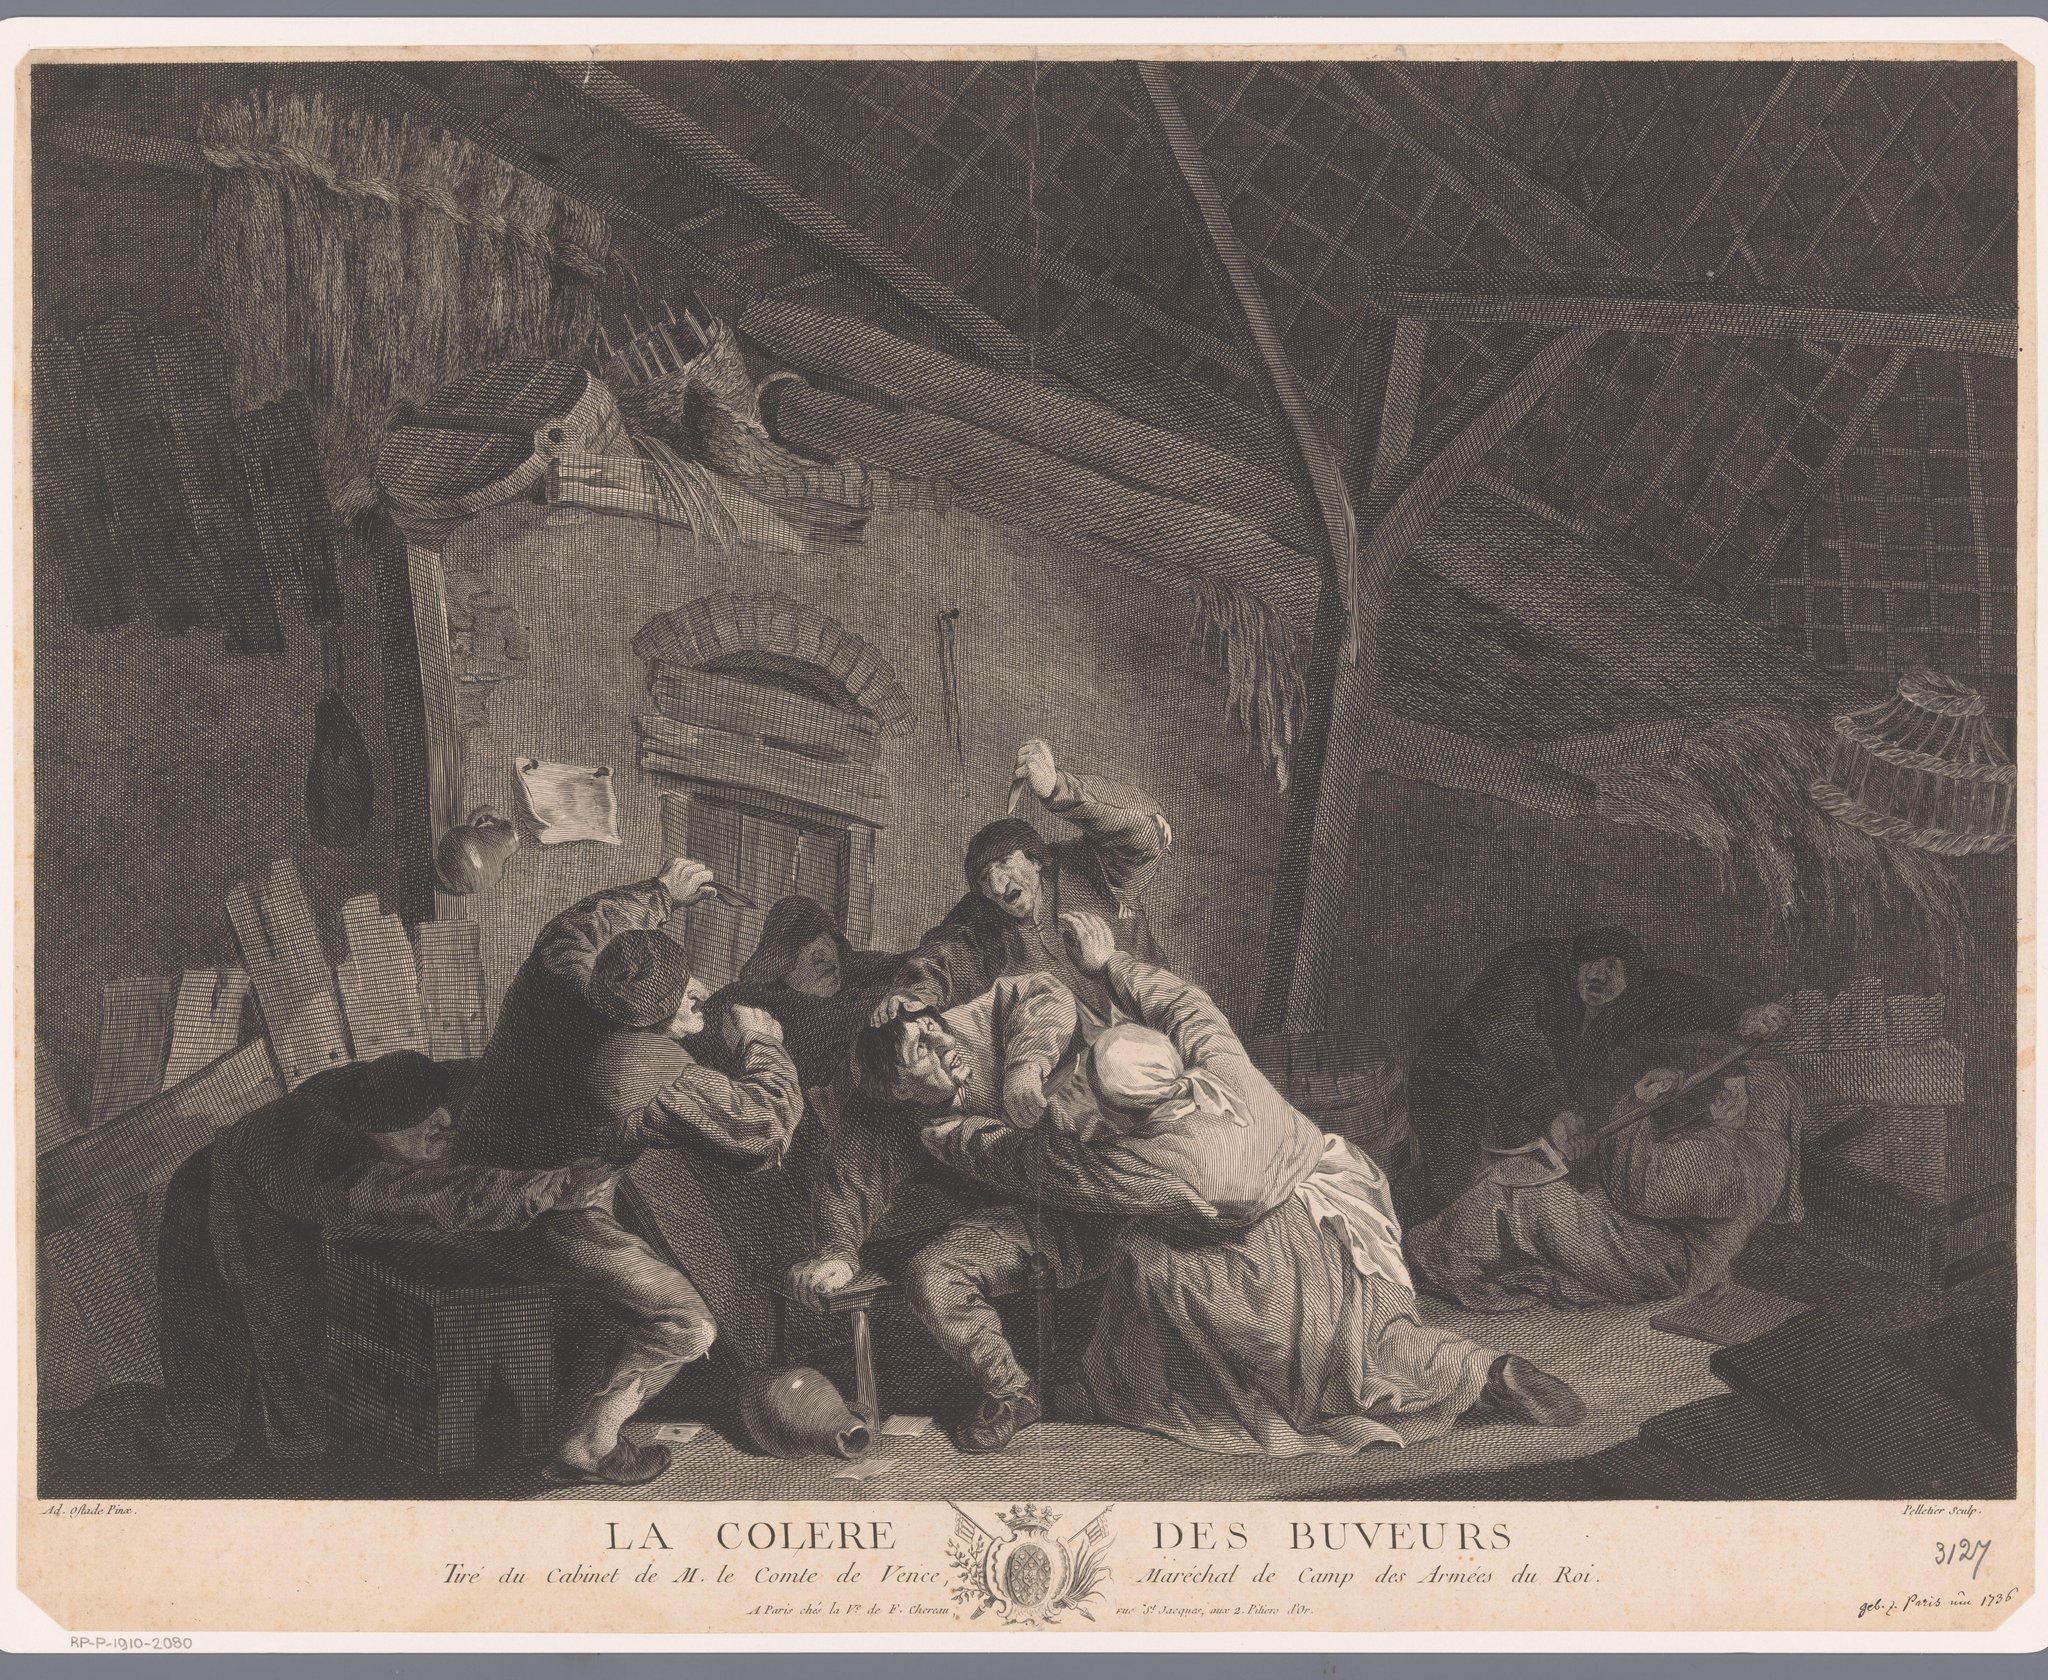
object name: print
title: Herberginterieur met vechtende mannen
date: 1746-1780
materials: paper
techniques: engraving, etching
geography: paris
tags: drunken brawl (usually peasants fighting in an inn)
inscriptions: collector's mark: Lugt 2228